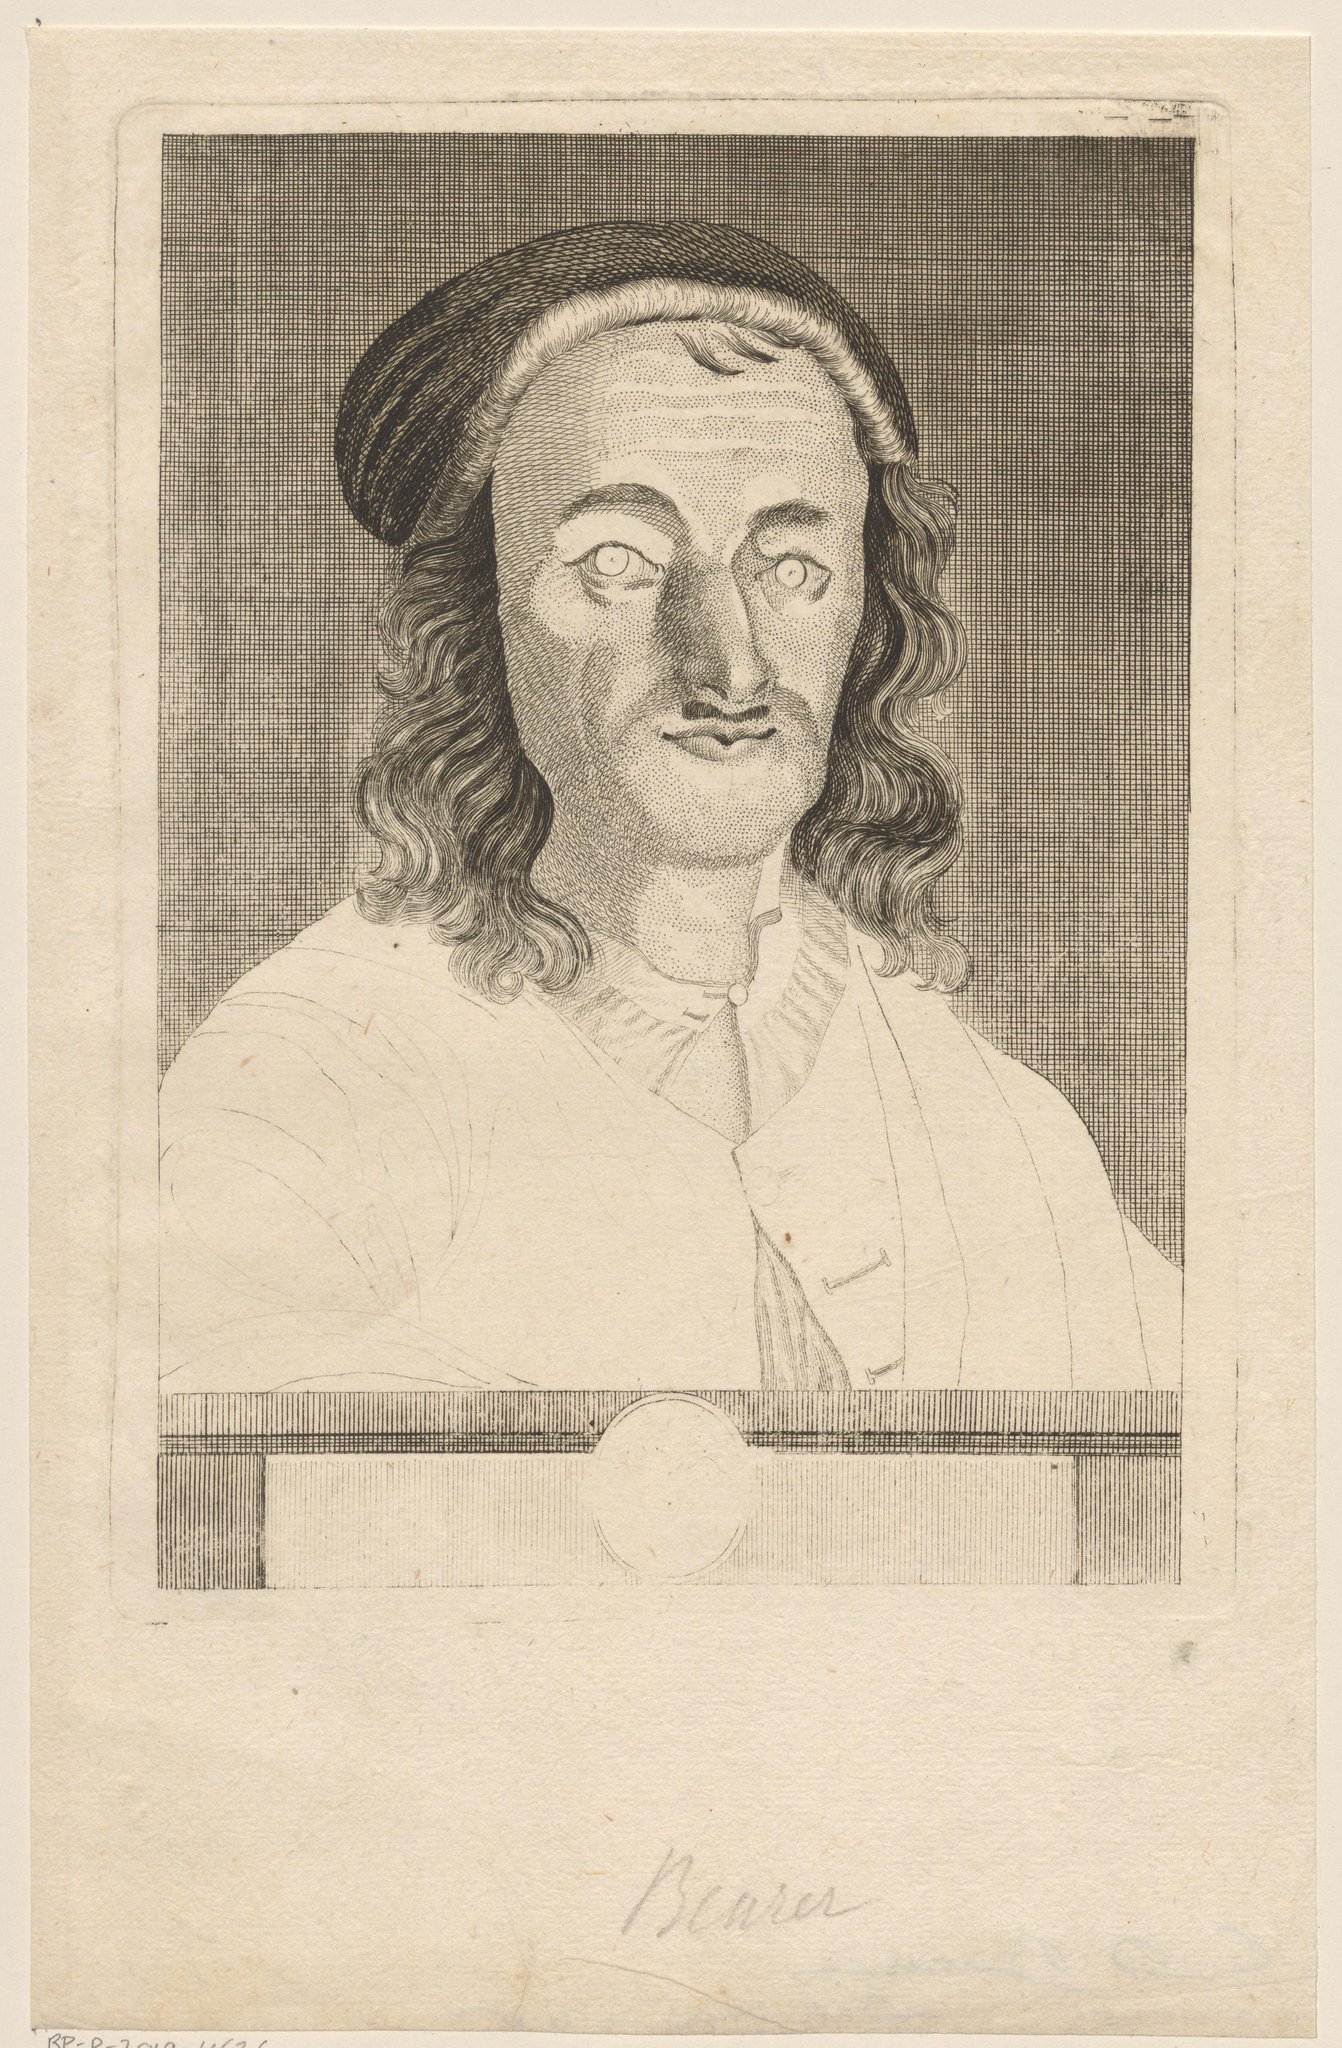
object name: print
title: Portret van Abraham Beurer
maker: johann christoph dehne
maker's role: print maker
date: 1714-1726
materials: paper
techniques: engraving, etching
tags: painter, historical persons, portrait, self-portrait of painter